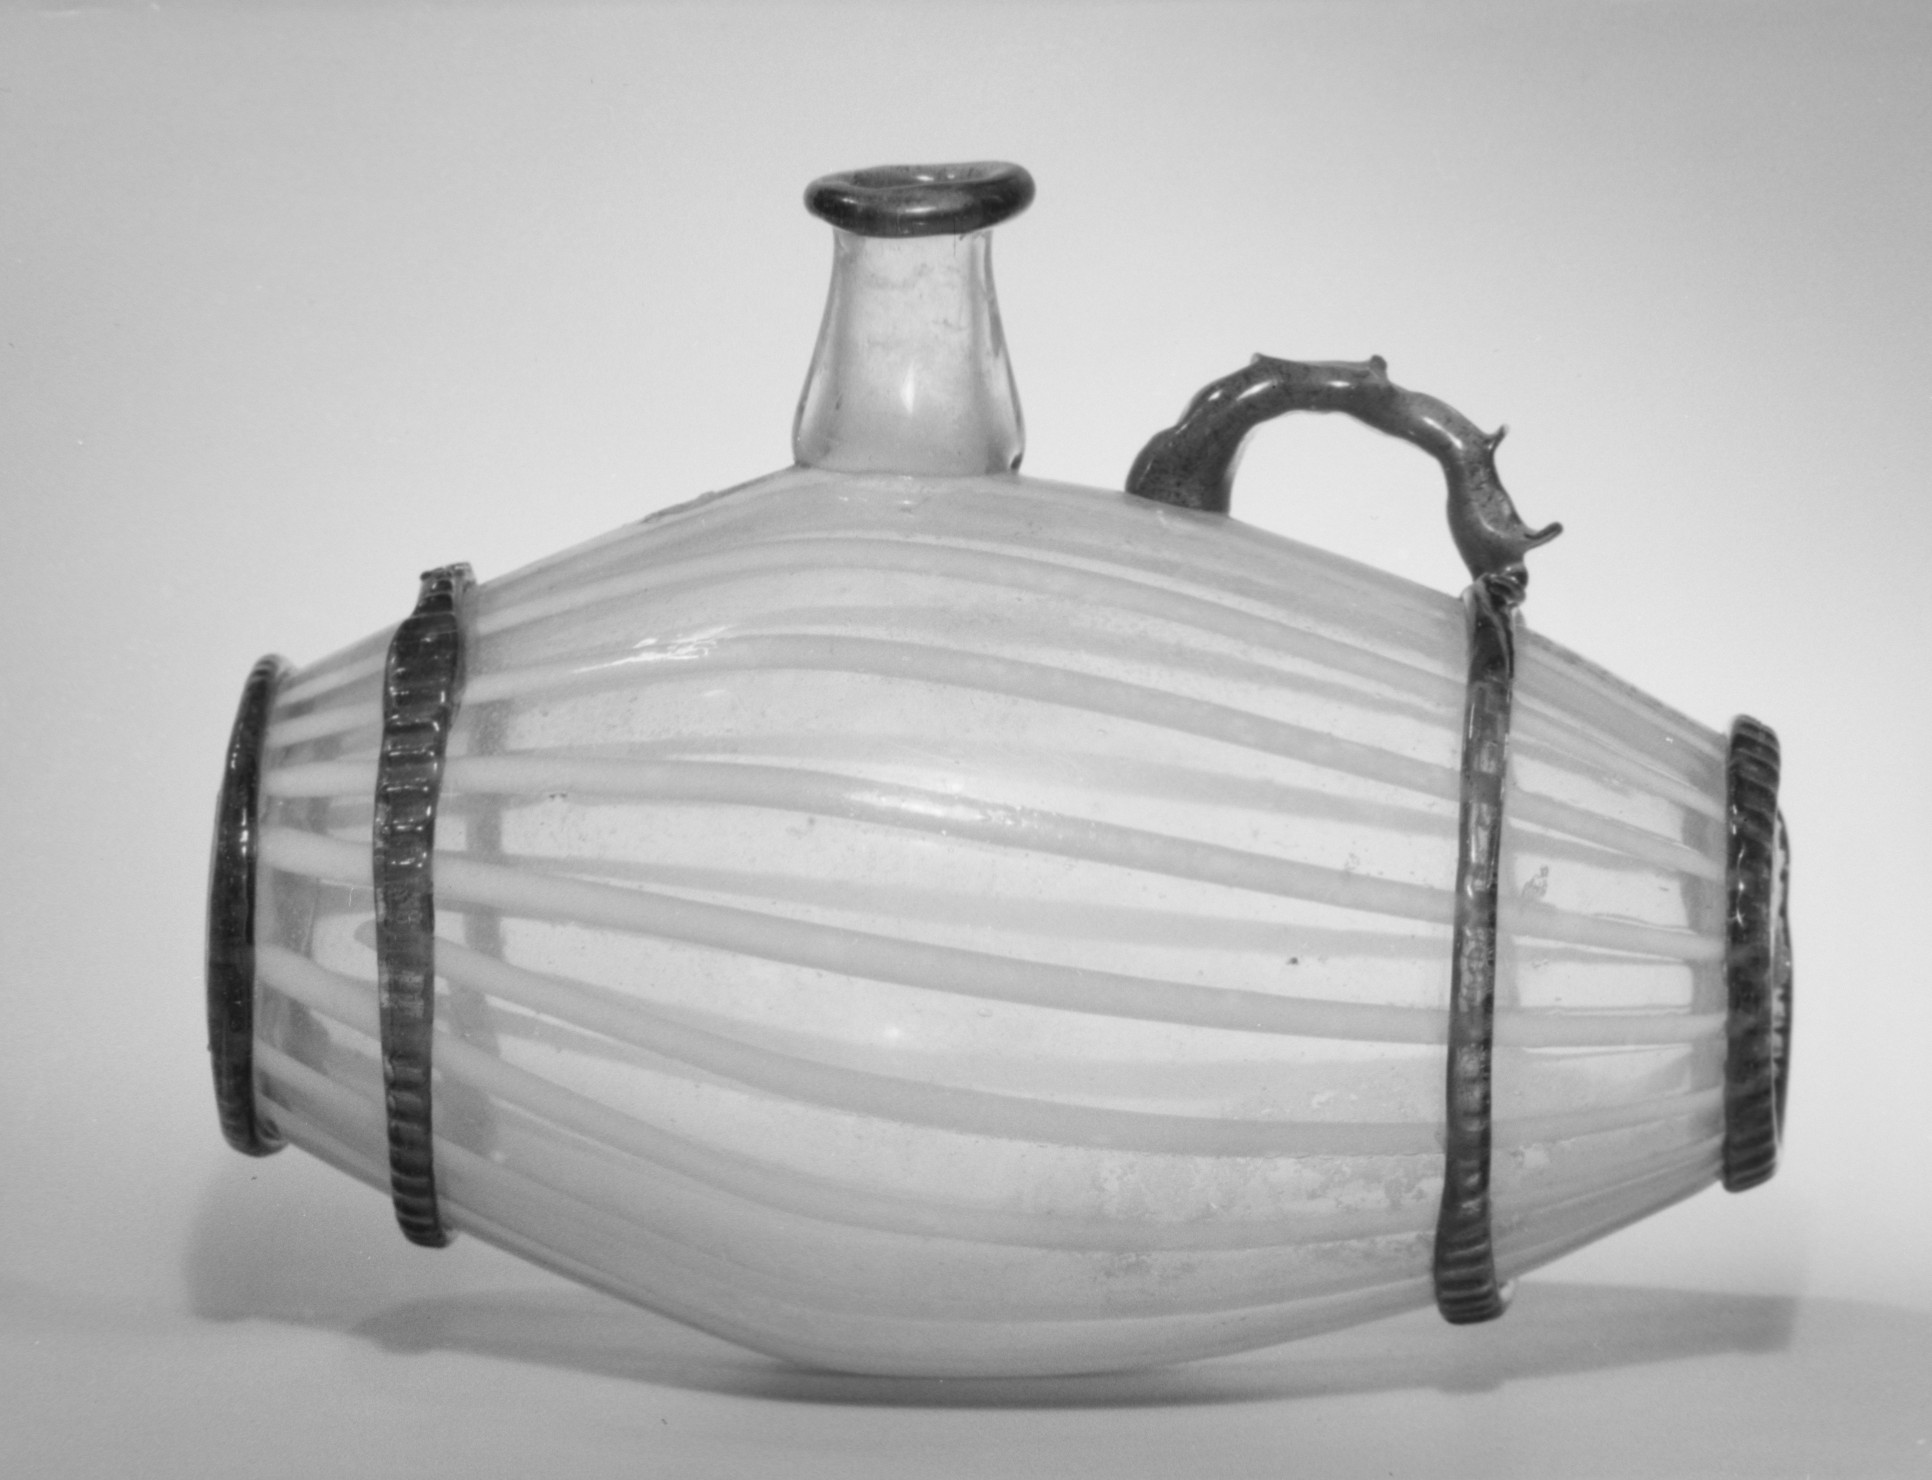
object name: flask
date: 1601-1700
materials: glass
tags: musical instruments